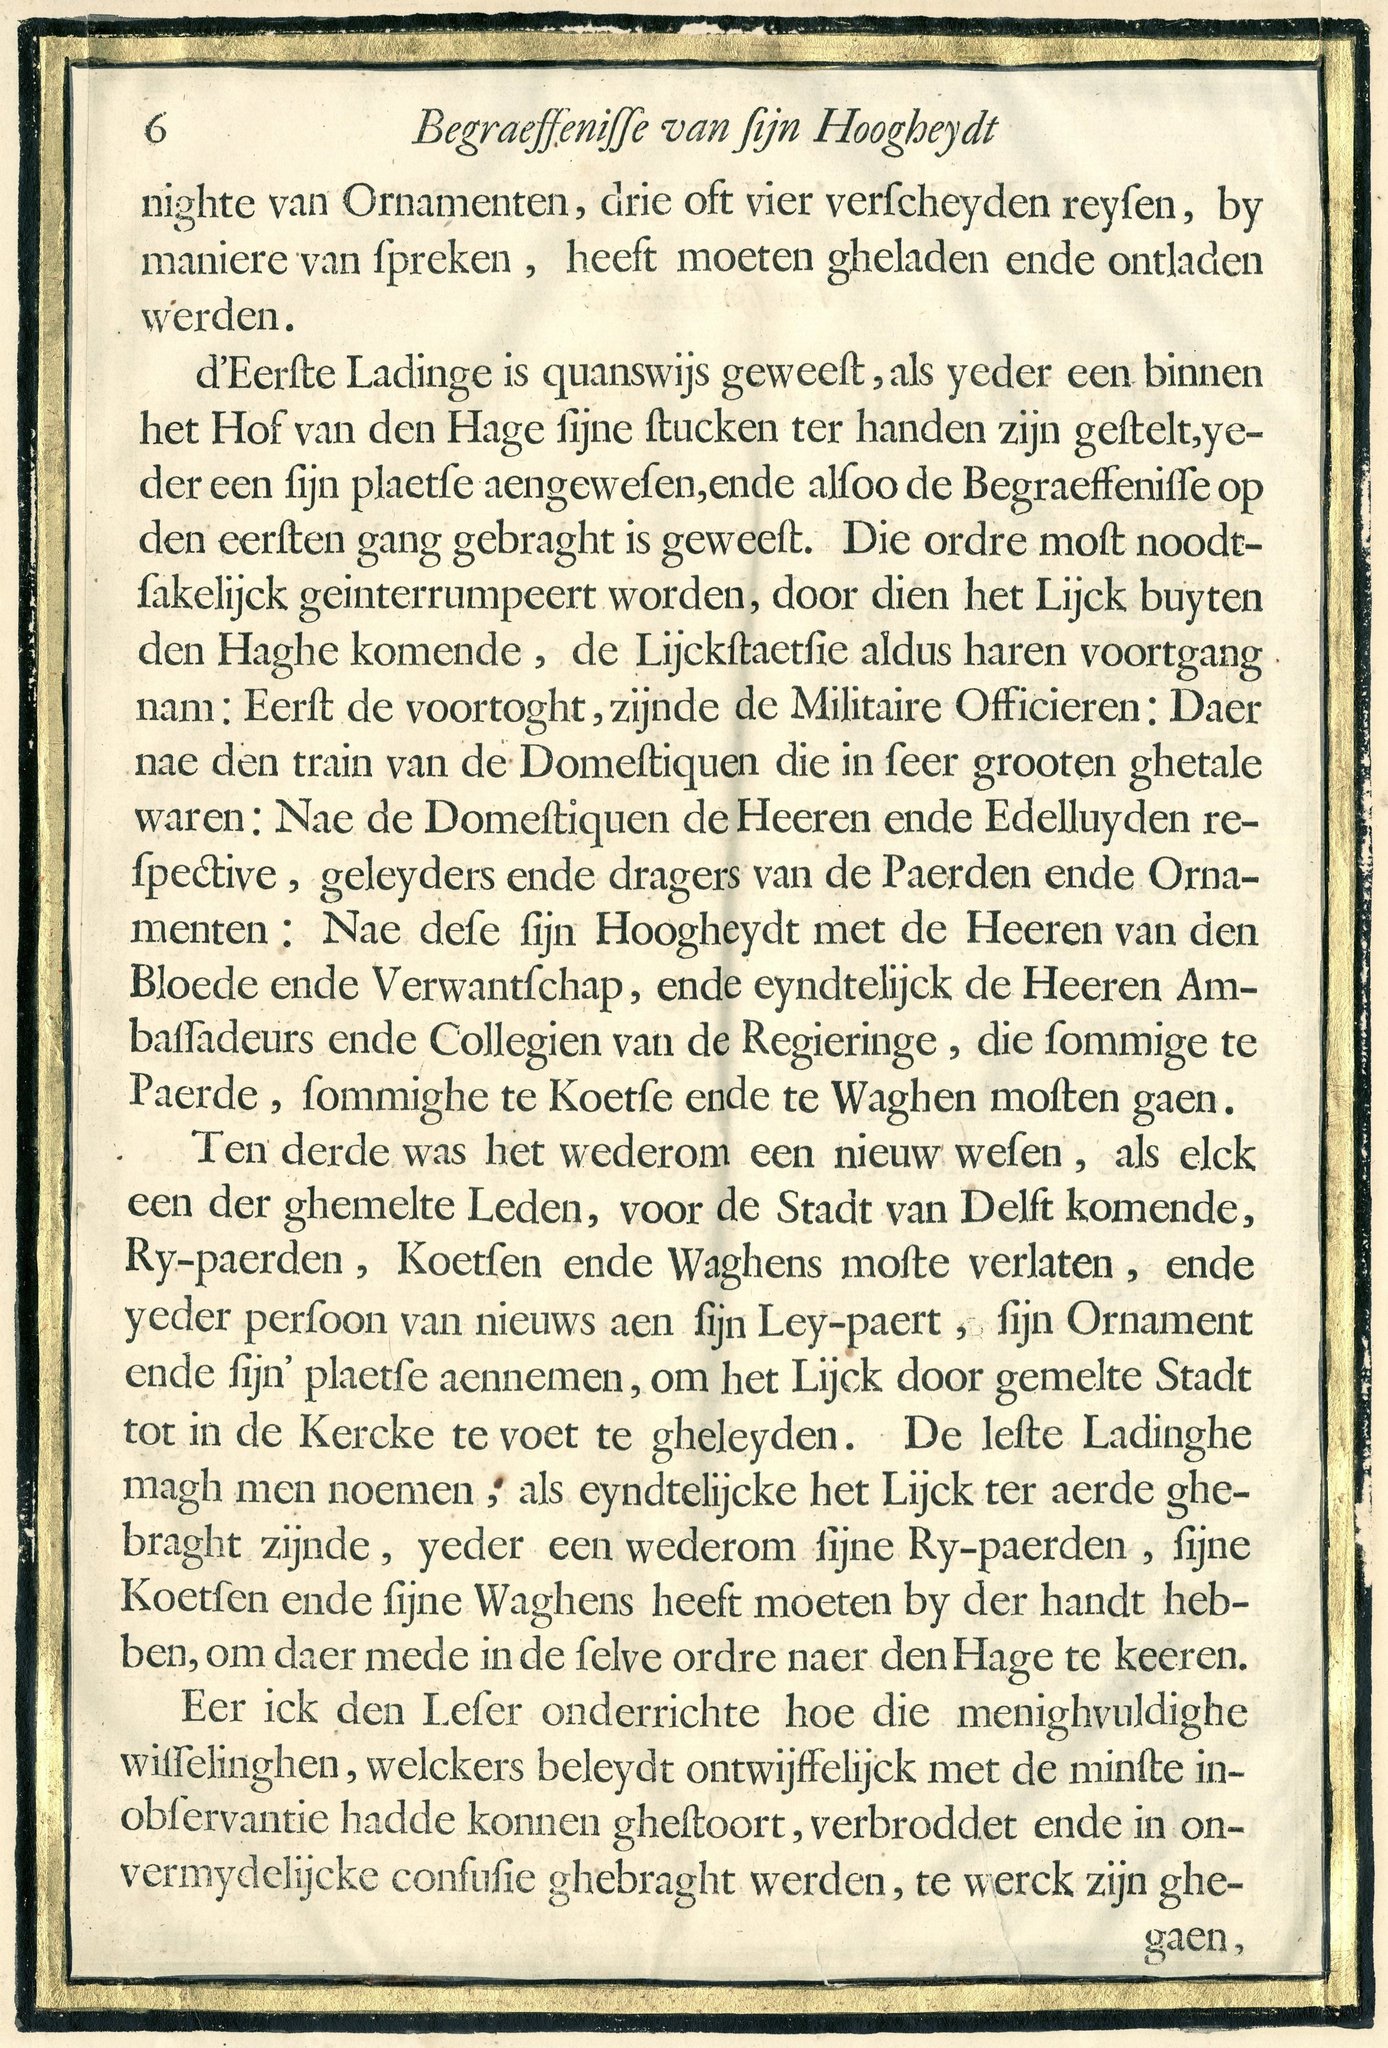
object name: text sheet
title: Begraeffenisse van syne hoogheyt Frederick Henrick. Luxe ingekleurde uitgave van de prenten van de begrafenisstoet van Frederik Hendrik in 1647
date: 1651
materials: paint, paper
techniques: letterpress printing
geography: amsterdam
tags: delft, frederick henry (prince of orange)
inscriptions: date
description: Pagina 6 van de beschrijving van de begrafenis van Frederik Hendrik. Blad uitgeknipt, versierd met goud en ingeplakt in de luxe editie uit ca. 1755 van het boek 'Begraeffenisse van syne hoogheyt Frederick Henrick' van Pieter Post, uitgegeven te Amsterdam in 1651.